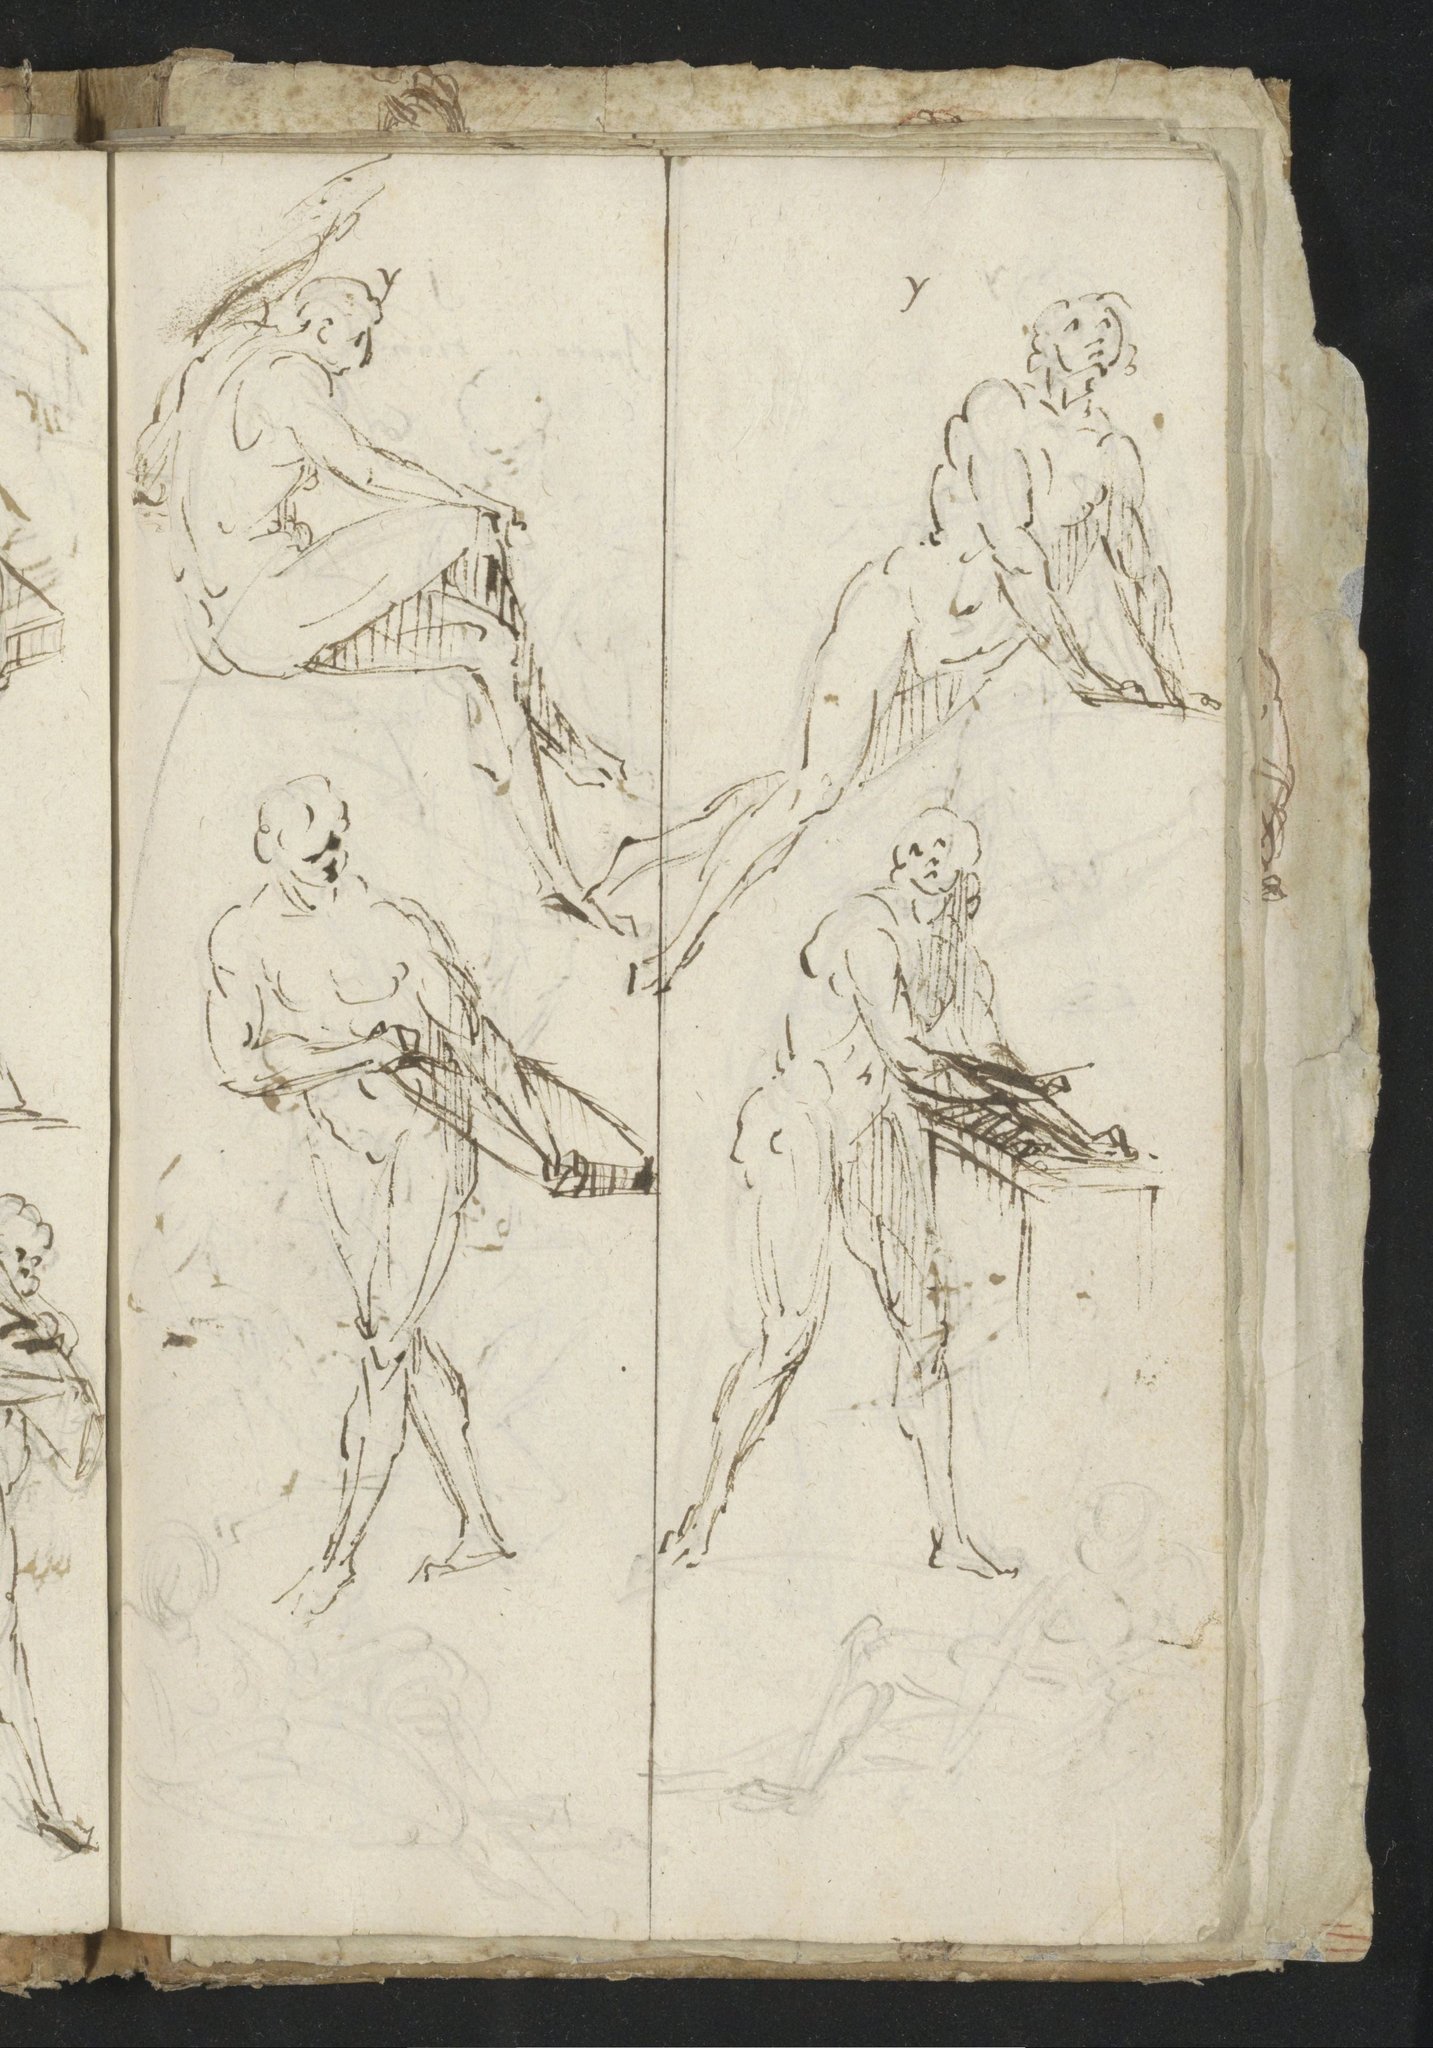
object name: sketchbook leaf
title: Zittende en liggende naakte mannen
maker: Anonymous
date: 1658-1728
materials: ink, paper, pencil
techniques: pen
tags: sitting figure, the (nude) human figure; 'corpo humano' (ripa), lying on one side, with uplifted upper part of the body and leaning on the arm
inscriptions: annotation: ‘y y’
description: Tevens studies van twee naakte mannen die een tablet dragen. Blad 21 recto uit een schetsboek met 33 bladen.